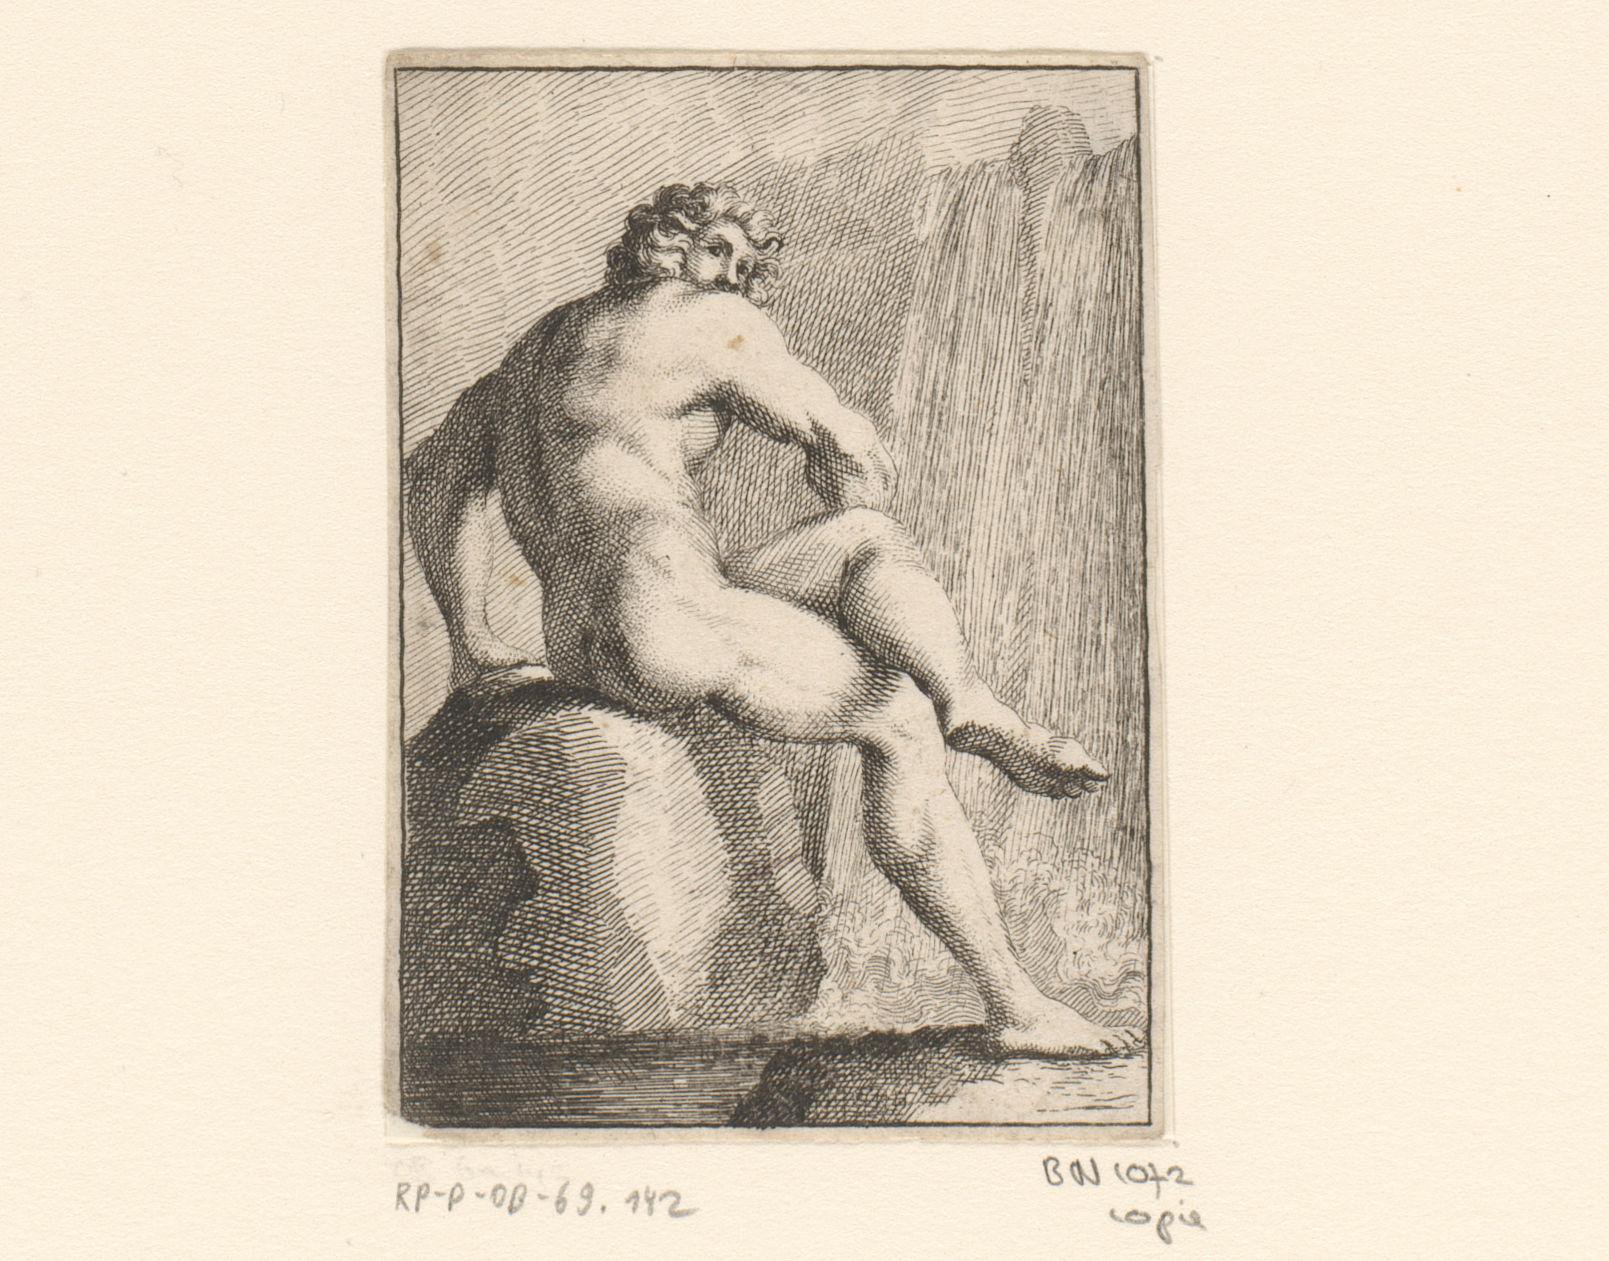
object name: print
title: Man op rotsblok, mogelijk Proteus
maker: Anonymous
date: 1647-1714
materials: paper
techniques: engraving, etching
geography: france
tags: proteus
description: Deze prent is een anonieme kopie naar de originele prent van Sébastien Leclerc.